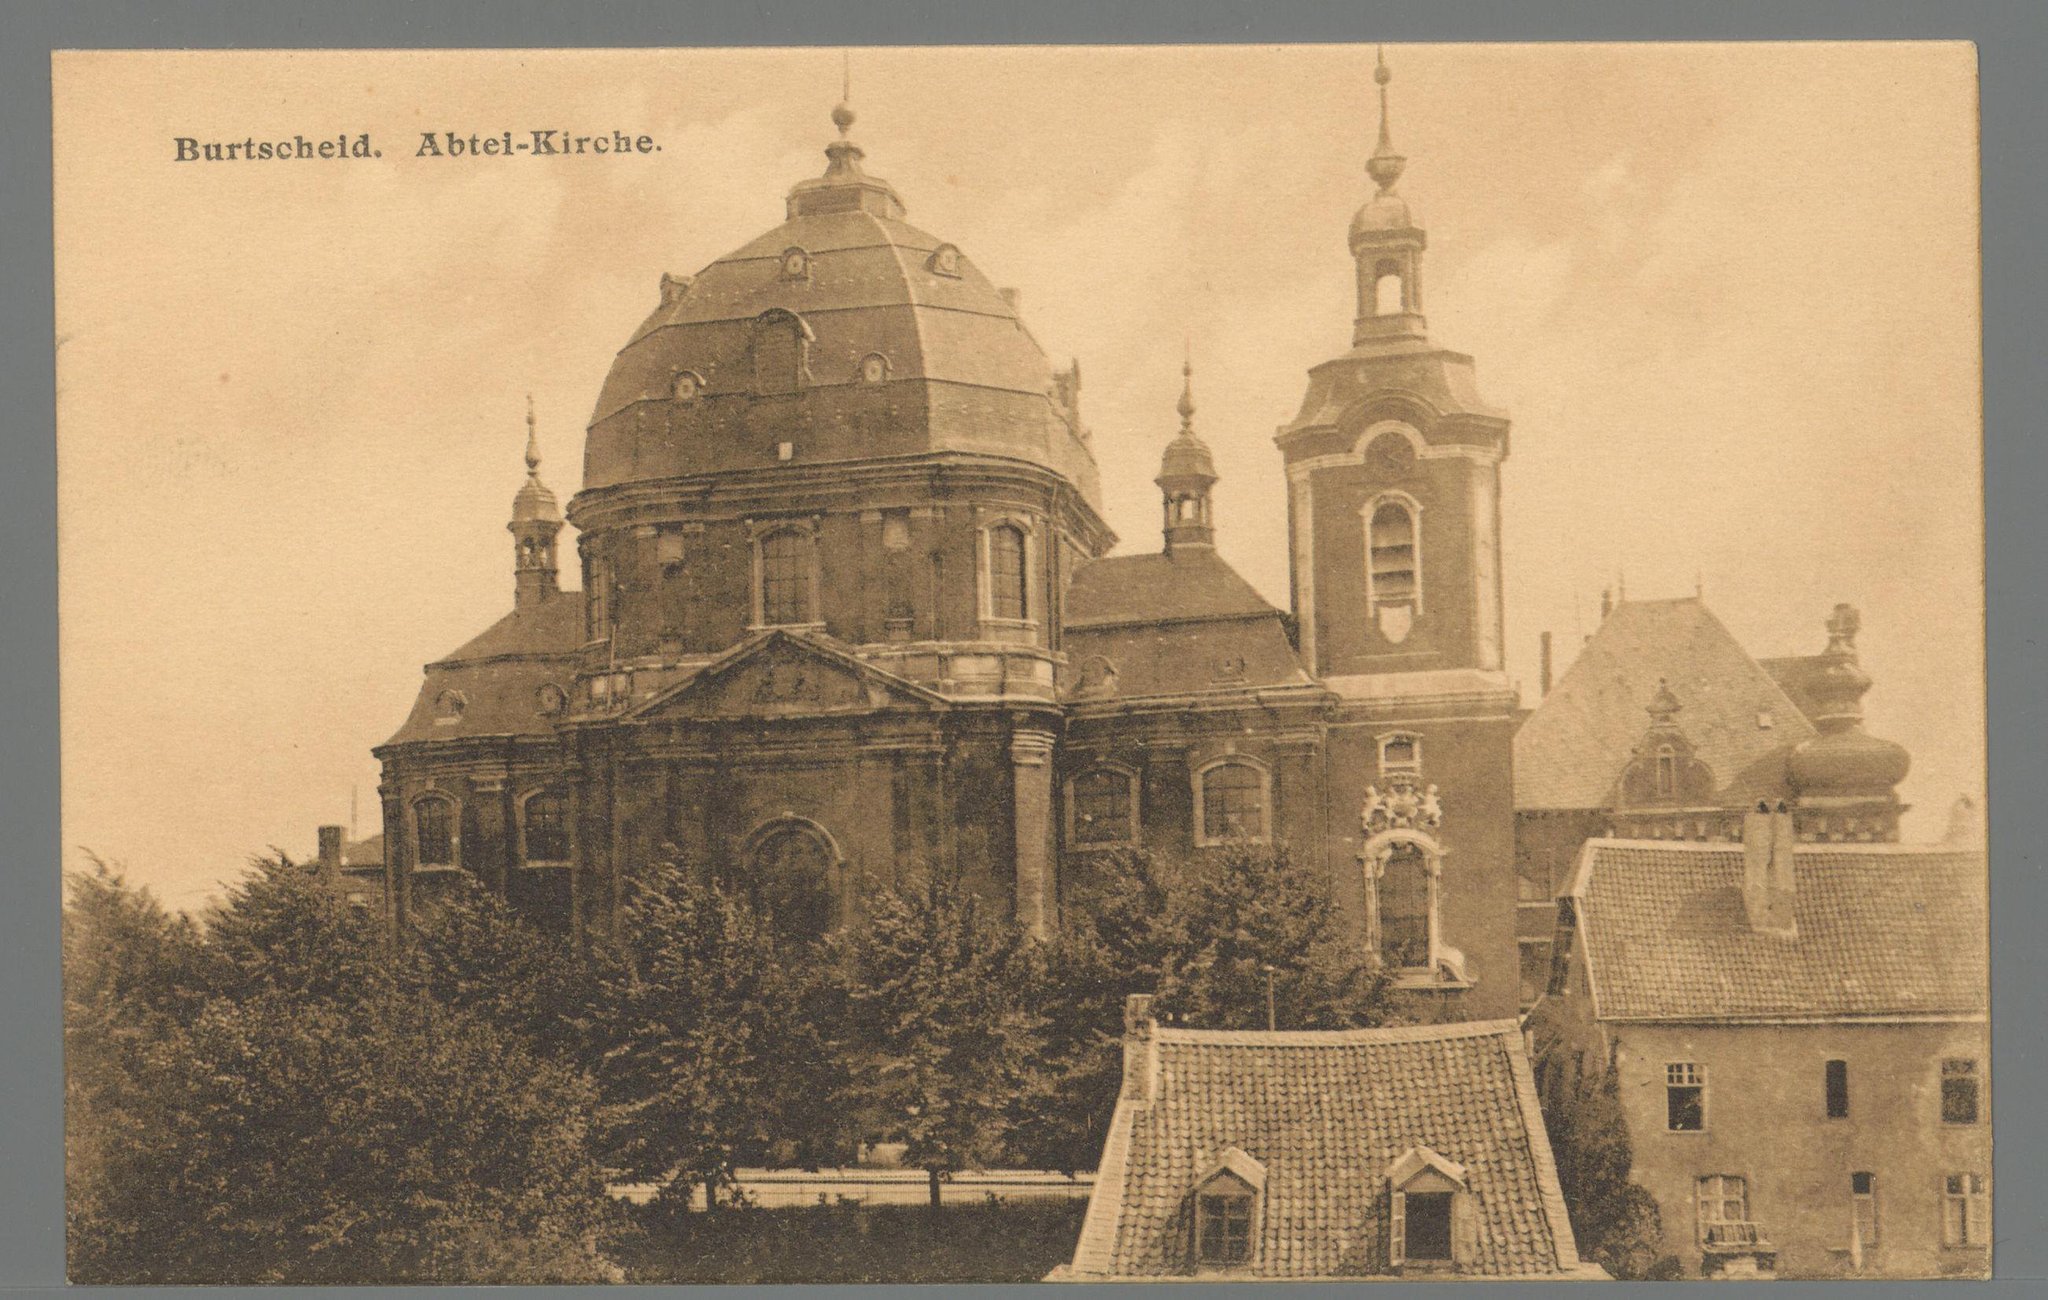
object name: ansichtkaart, prentbriefkaart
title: Burtscheid. Abtei-Kirche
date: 1905-1930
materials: cardboard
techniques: photograph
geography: burtscheid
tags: church (exterior)